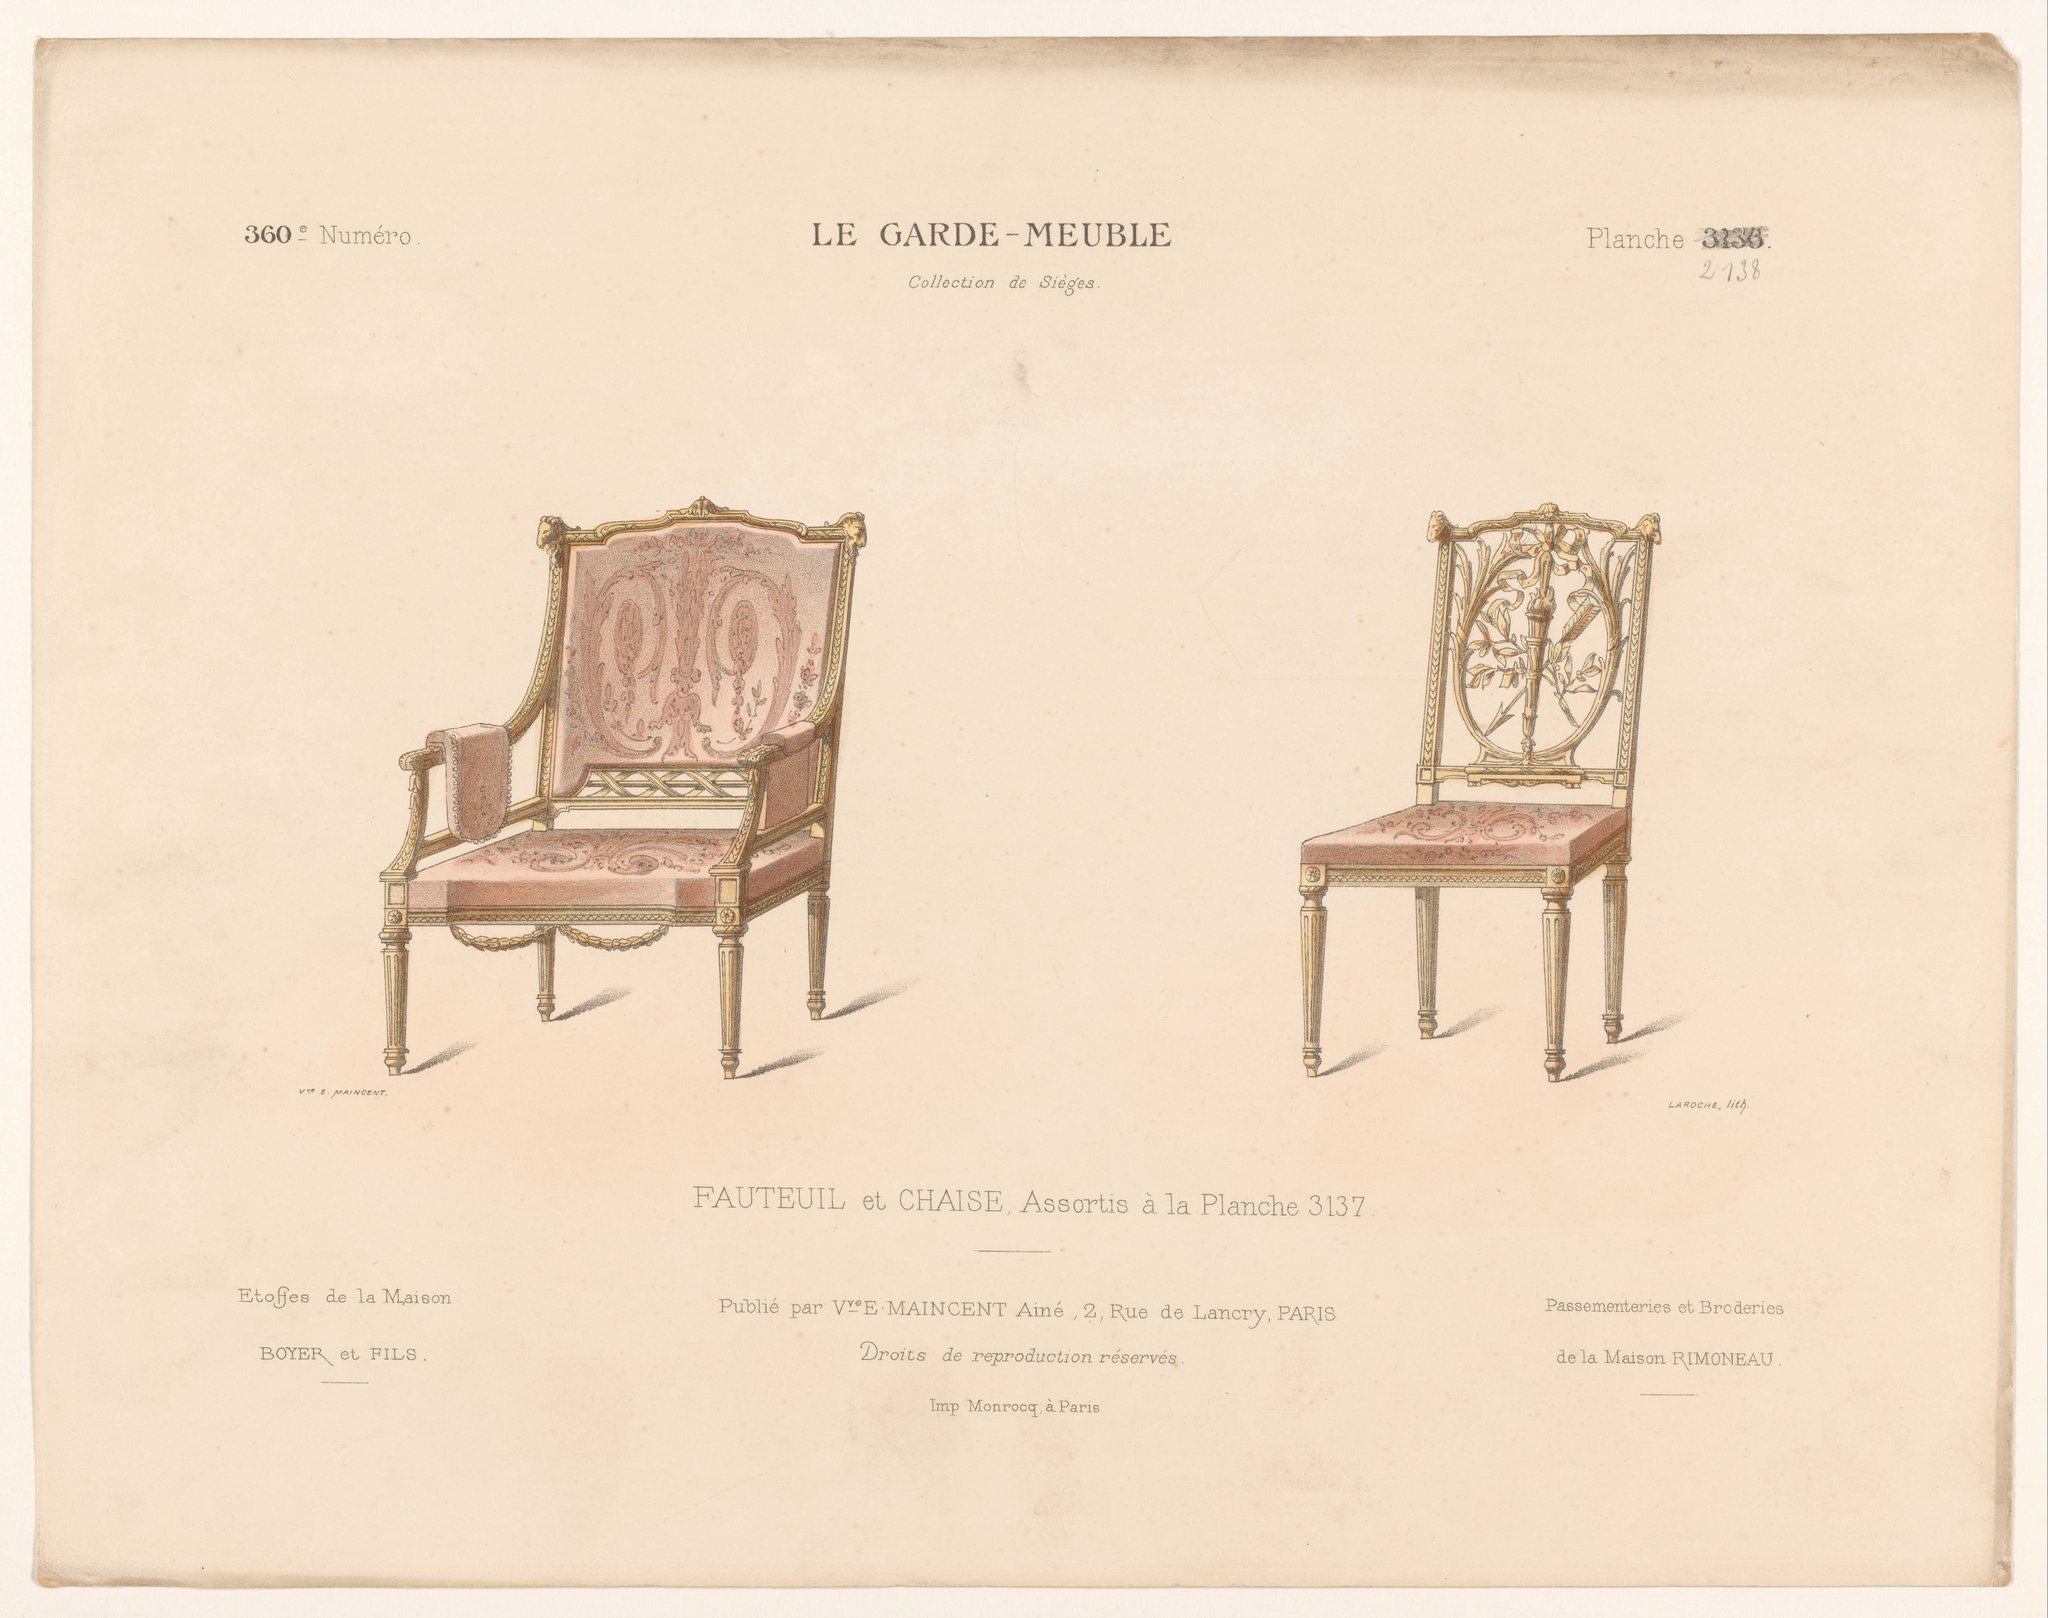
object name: print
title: Fauteuil en stoel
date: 1895-1935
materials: paper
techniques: hand coloring, lithograph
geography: paris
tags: seating furniture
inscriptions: number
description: Ieder Livraison in de serie Le Garde-Meuble bevat negen platen: drie 'sièges' (zitmeubels), drie 'meubles' (diverse meubels zoals tafels en kasten) en drie 'tentures' (gordijnen en draperieën).